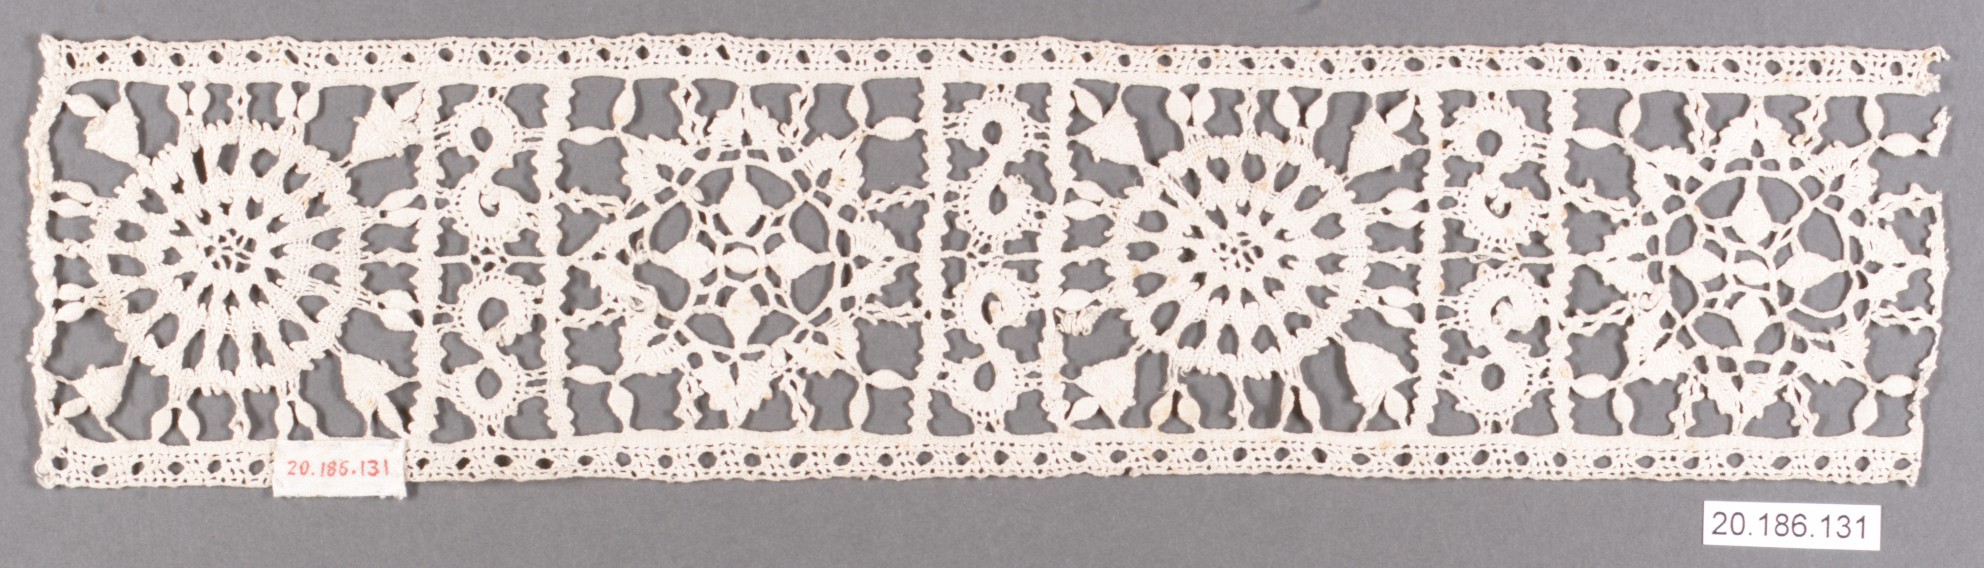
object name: insertion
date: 1501-1600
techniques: lace